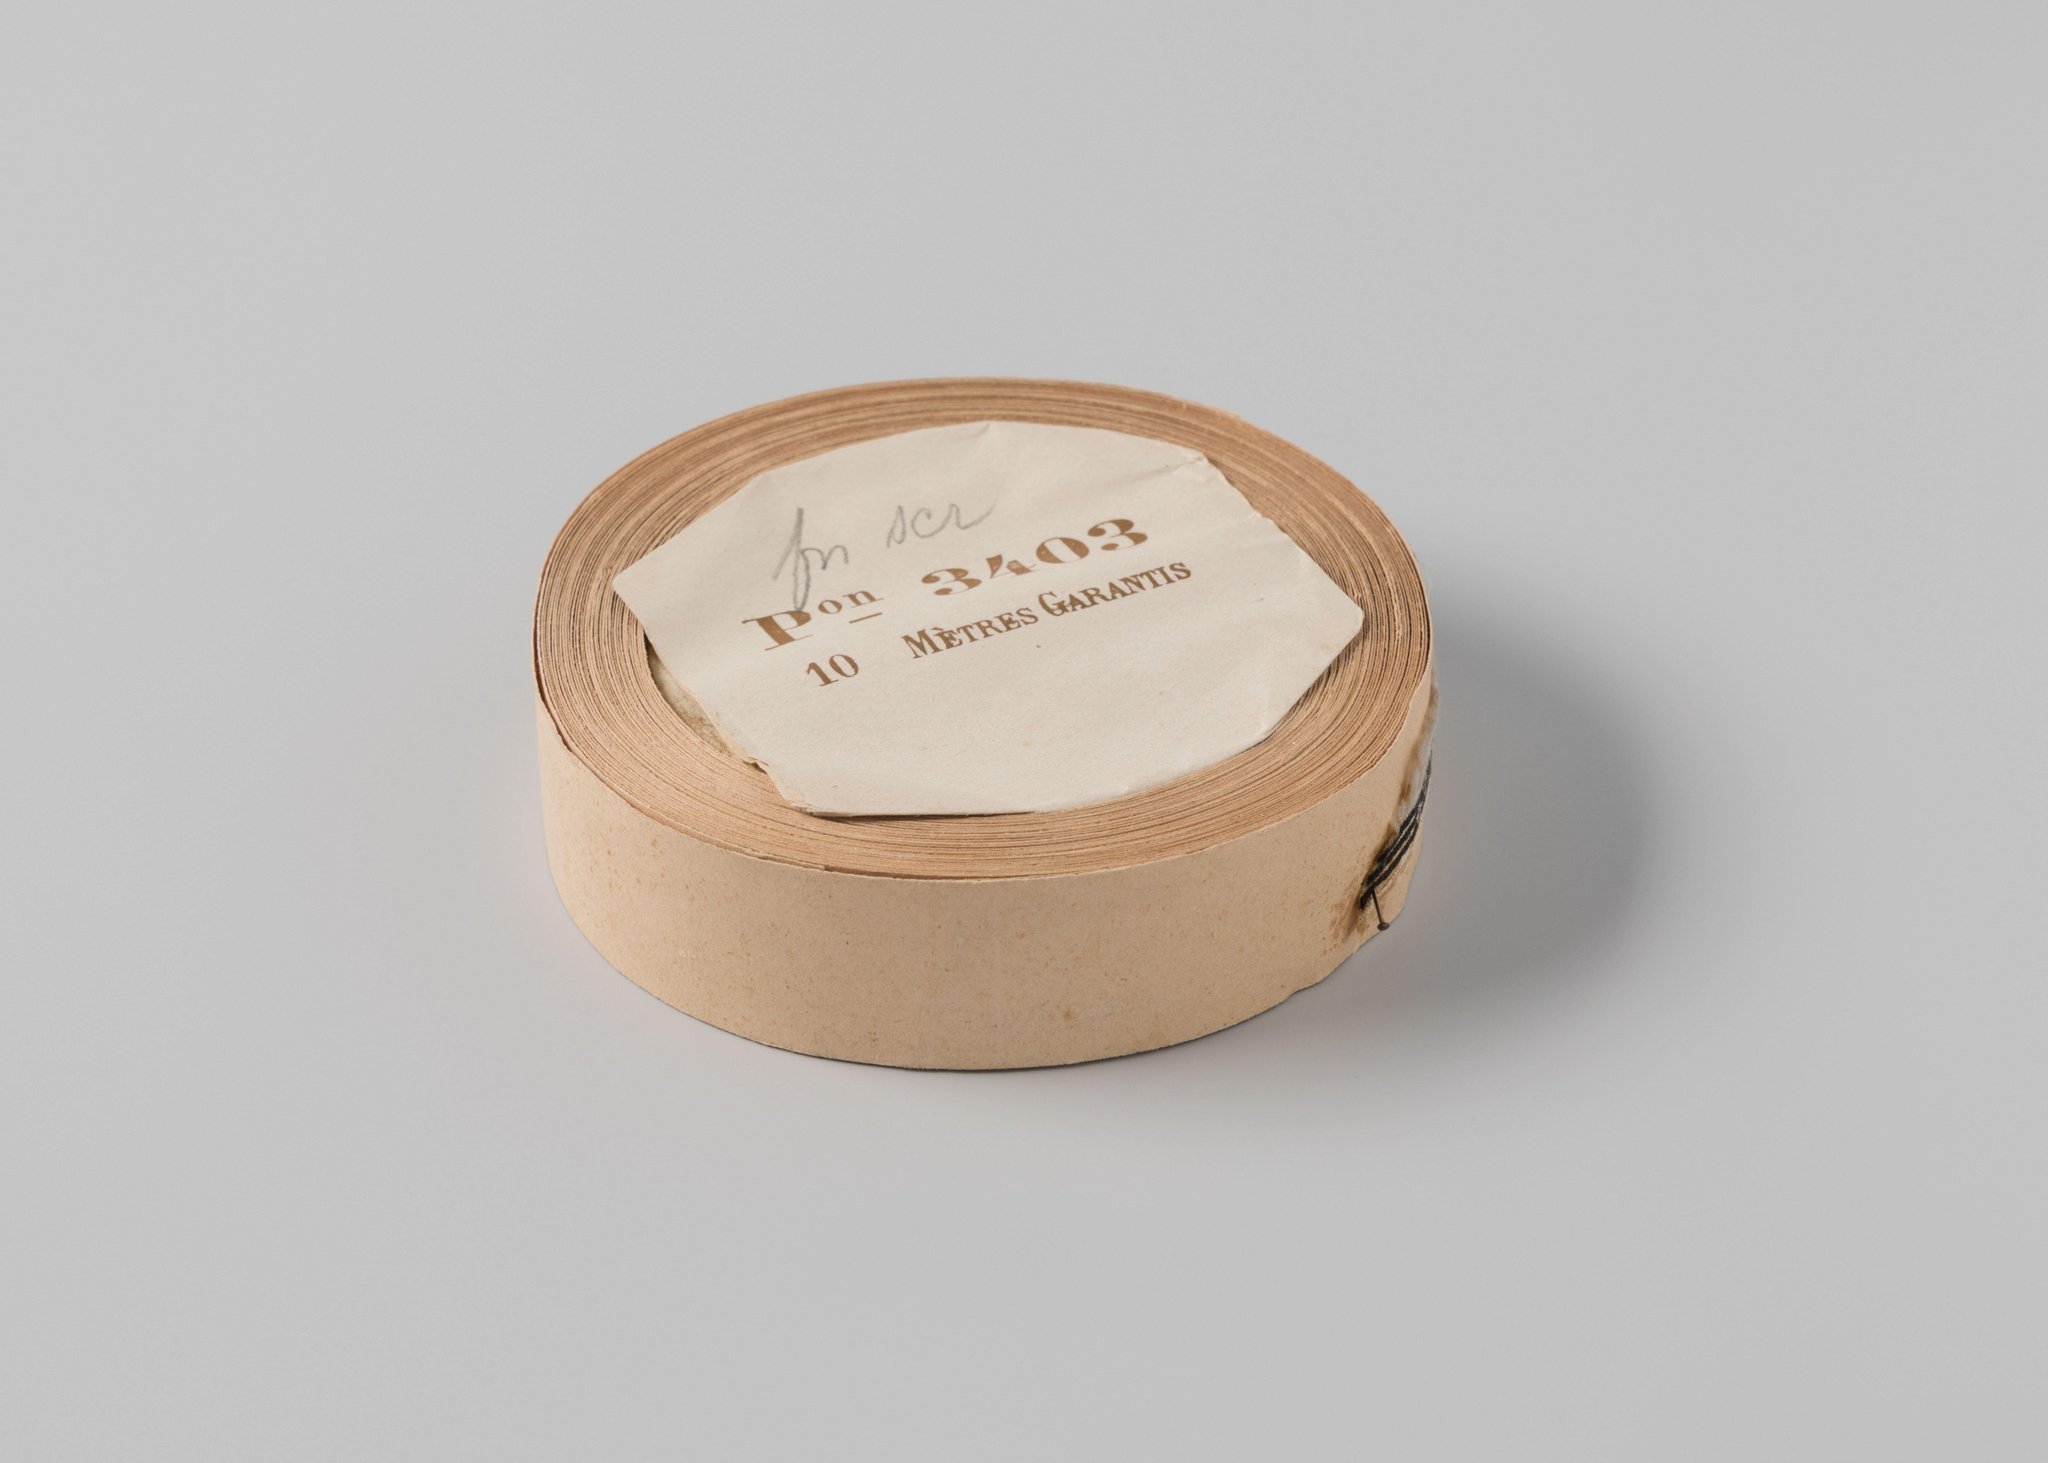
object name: ribbon material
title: Rol met wit lint met één gerafelde zijde en drie zwarte horizontale strepen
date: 1930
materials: cardboard, paper, textile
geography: nijmegen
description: Rol met wit lint met één gerafelde zijde en drie zwarte horizontale strepen.